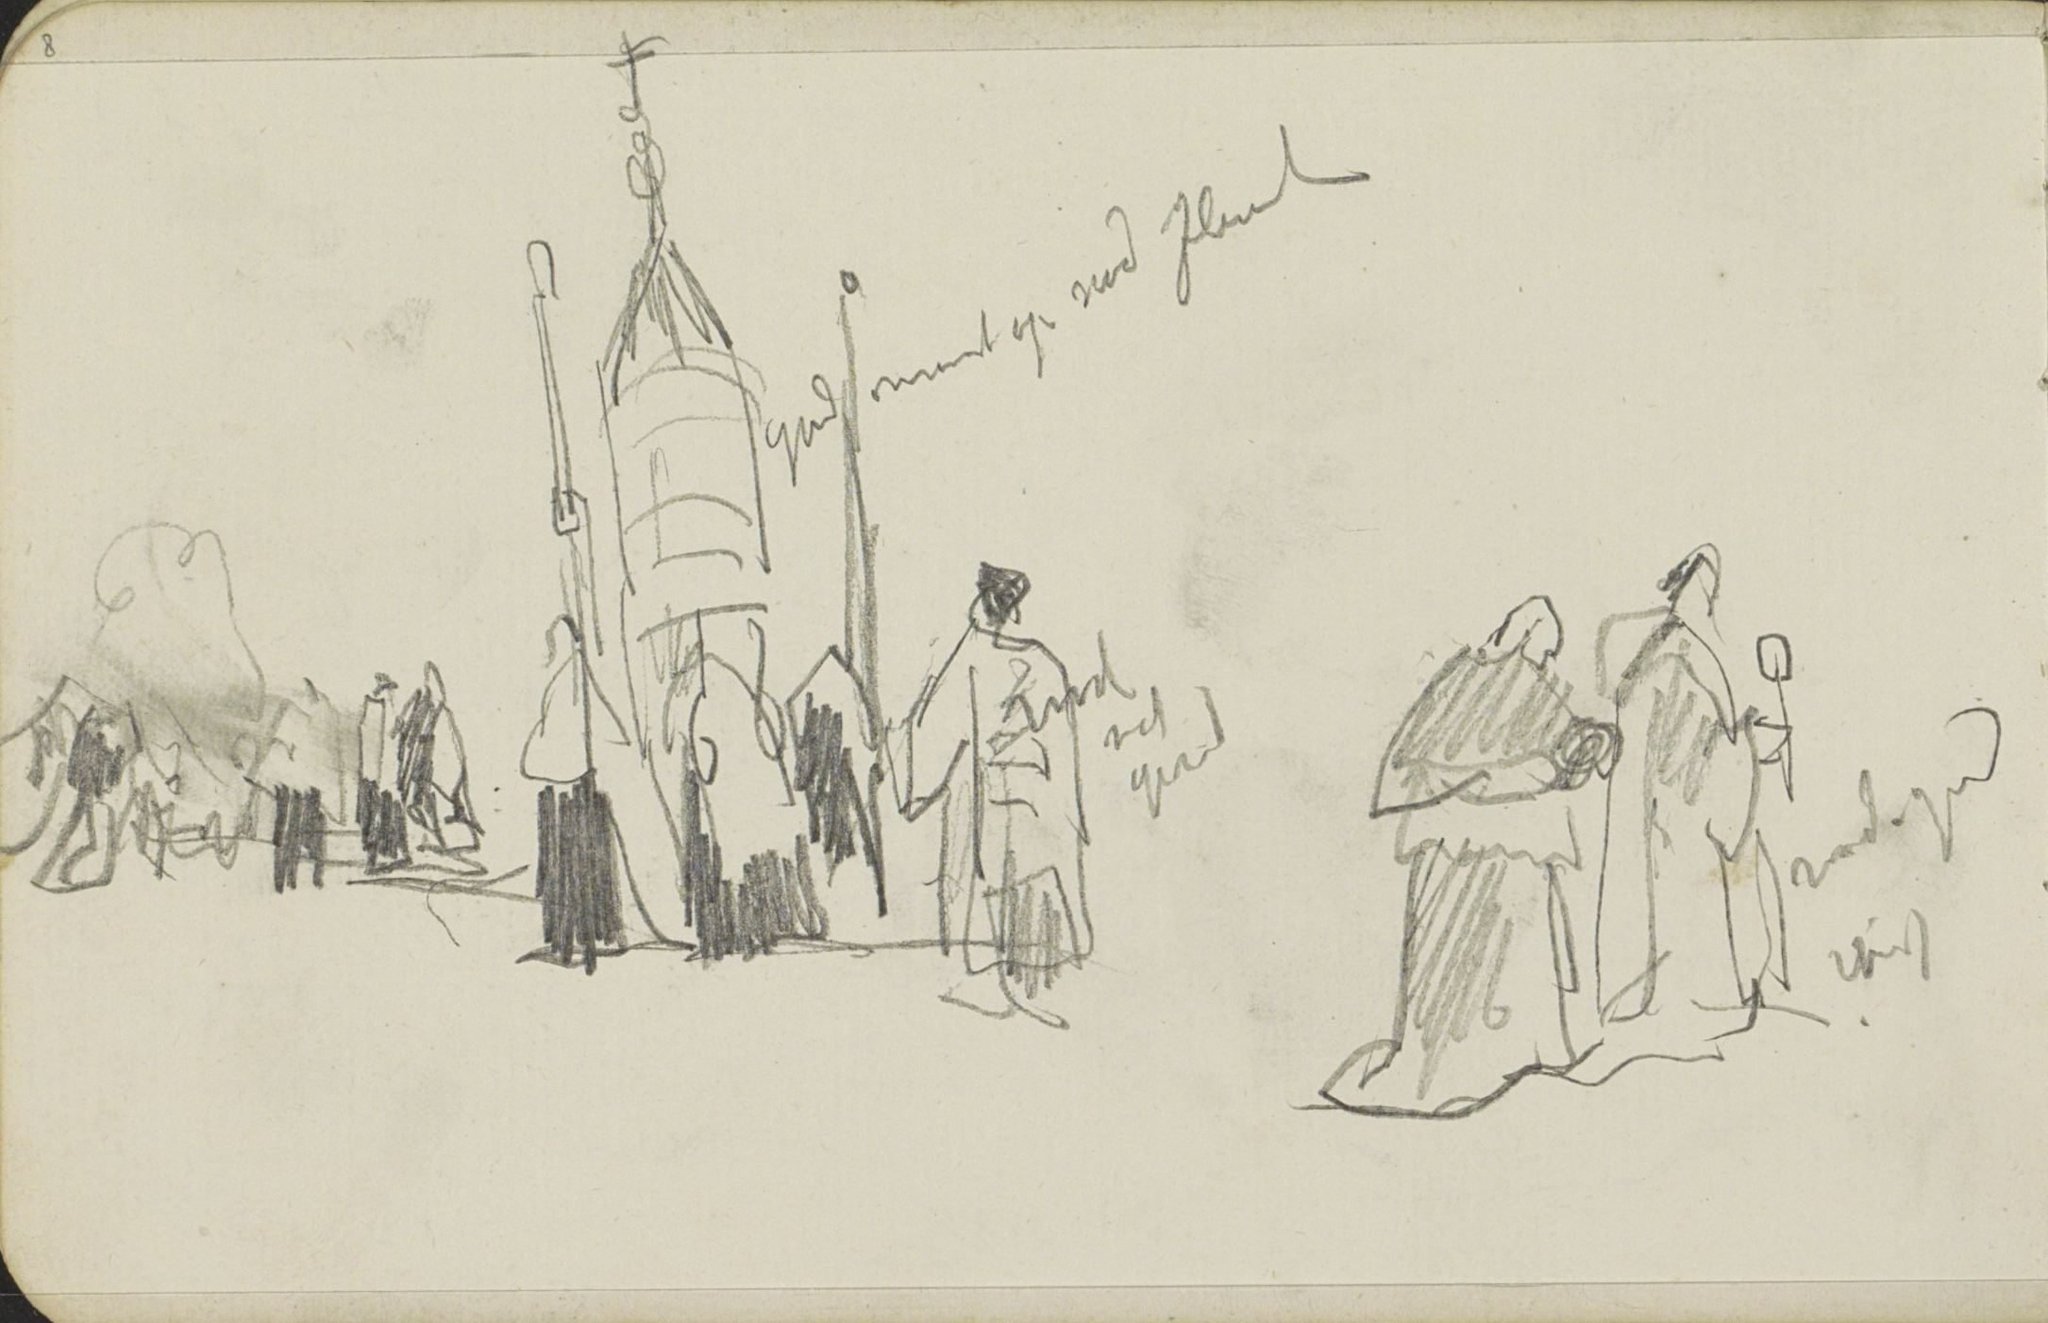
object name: sketchbook leaf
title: Straat met figuren bij een toren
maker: marius bauer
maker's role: draughtsman, print maker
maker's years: 1867-1932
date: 1902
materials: paper, pencil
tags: procession ~ christian religion, tower (of house or building), street (+ city(-scape) with figures, staffage)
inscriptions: kleurnotitie, handgeschreven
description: Mogelijk lopen de figuren in een religieuze processie. Pagina 8 uit een schetsboek met 30 bladen.